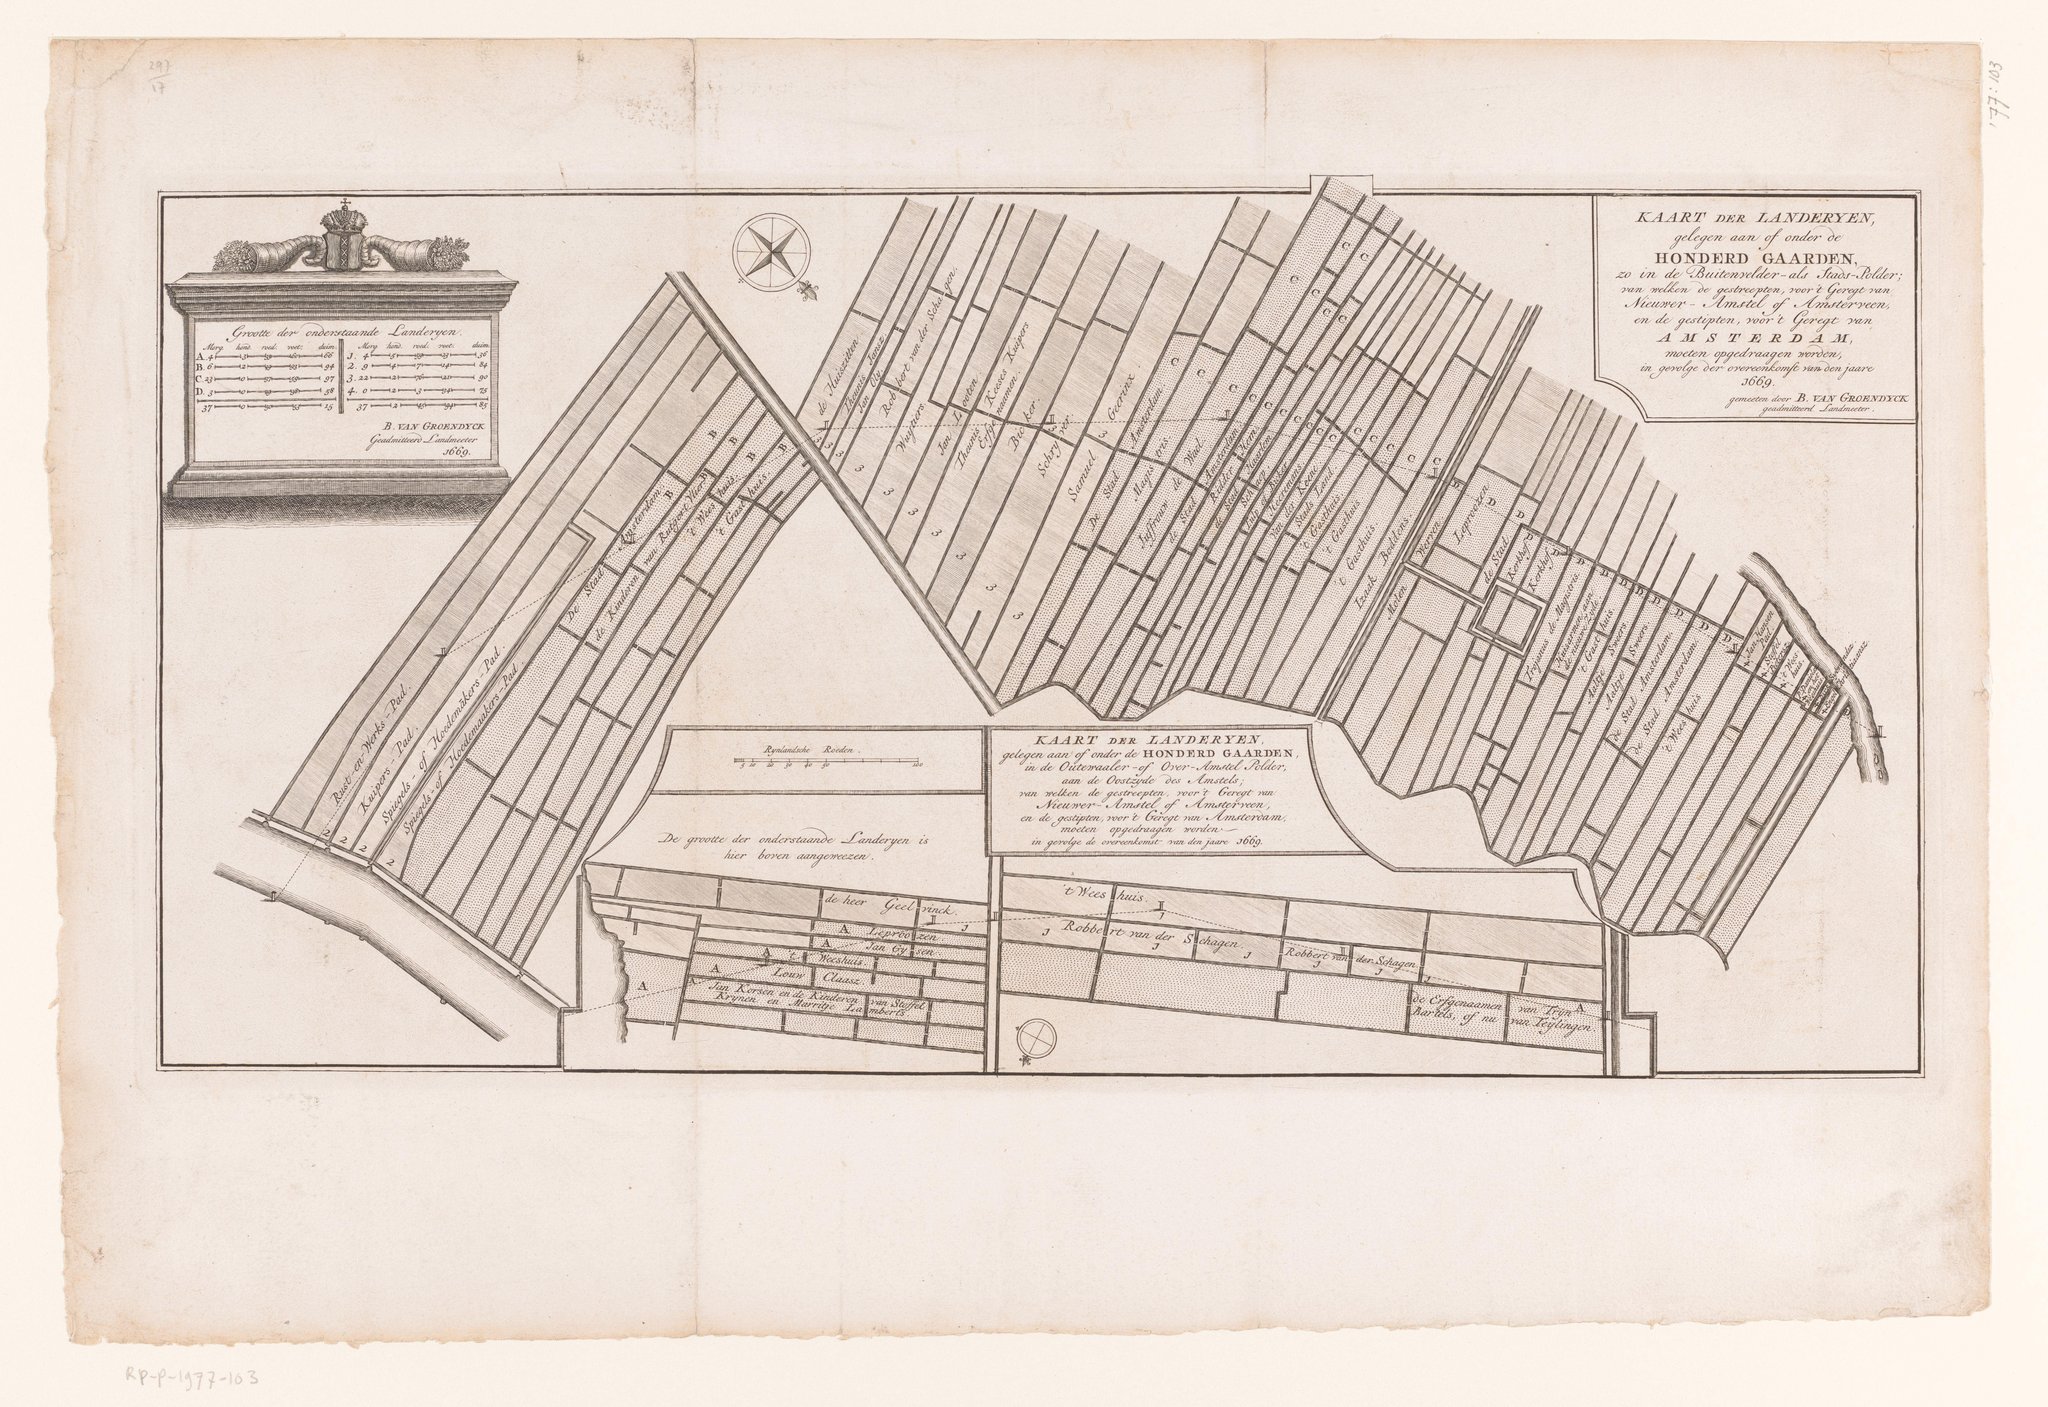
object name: print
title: Kaart van de landerijen in Buitenveldert te Amsterdam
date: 1767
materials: paper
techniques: etching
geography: amsterdam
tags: maps of separate countries or regions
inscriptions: collector's mark: Lugt 2760, collector's mark: Lugt 2228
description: Prent mogelijk uit: Wagenaar, Jan. Amsterdam in zyne opkomst, aanwas, geschiedenissen (...). Amsterdam: Yntema & Tieboel, 1767, dl. 11.